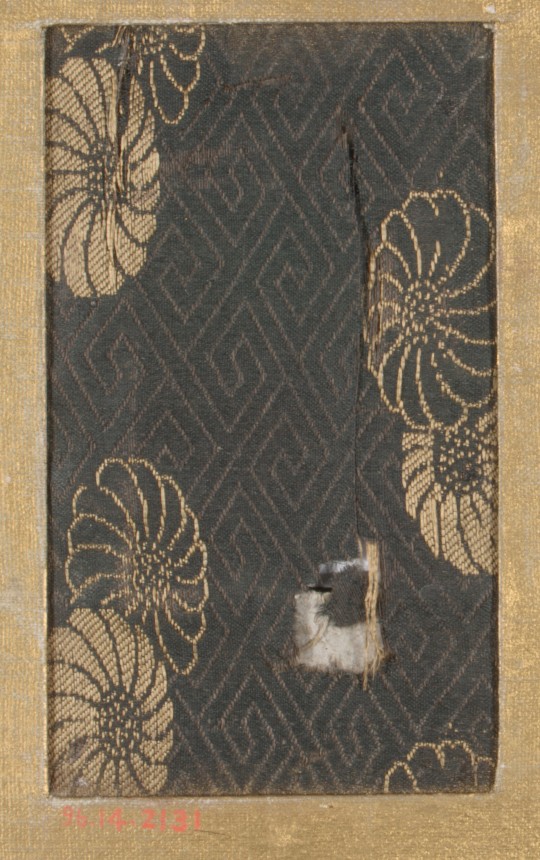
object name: piece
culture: japanese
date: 1701-1900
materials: silk